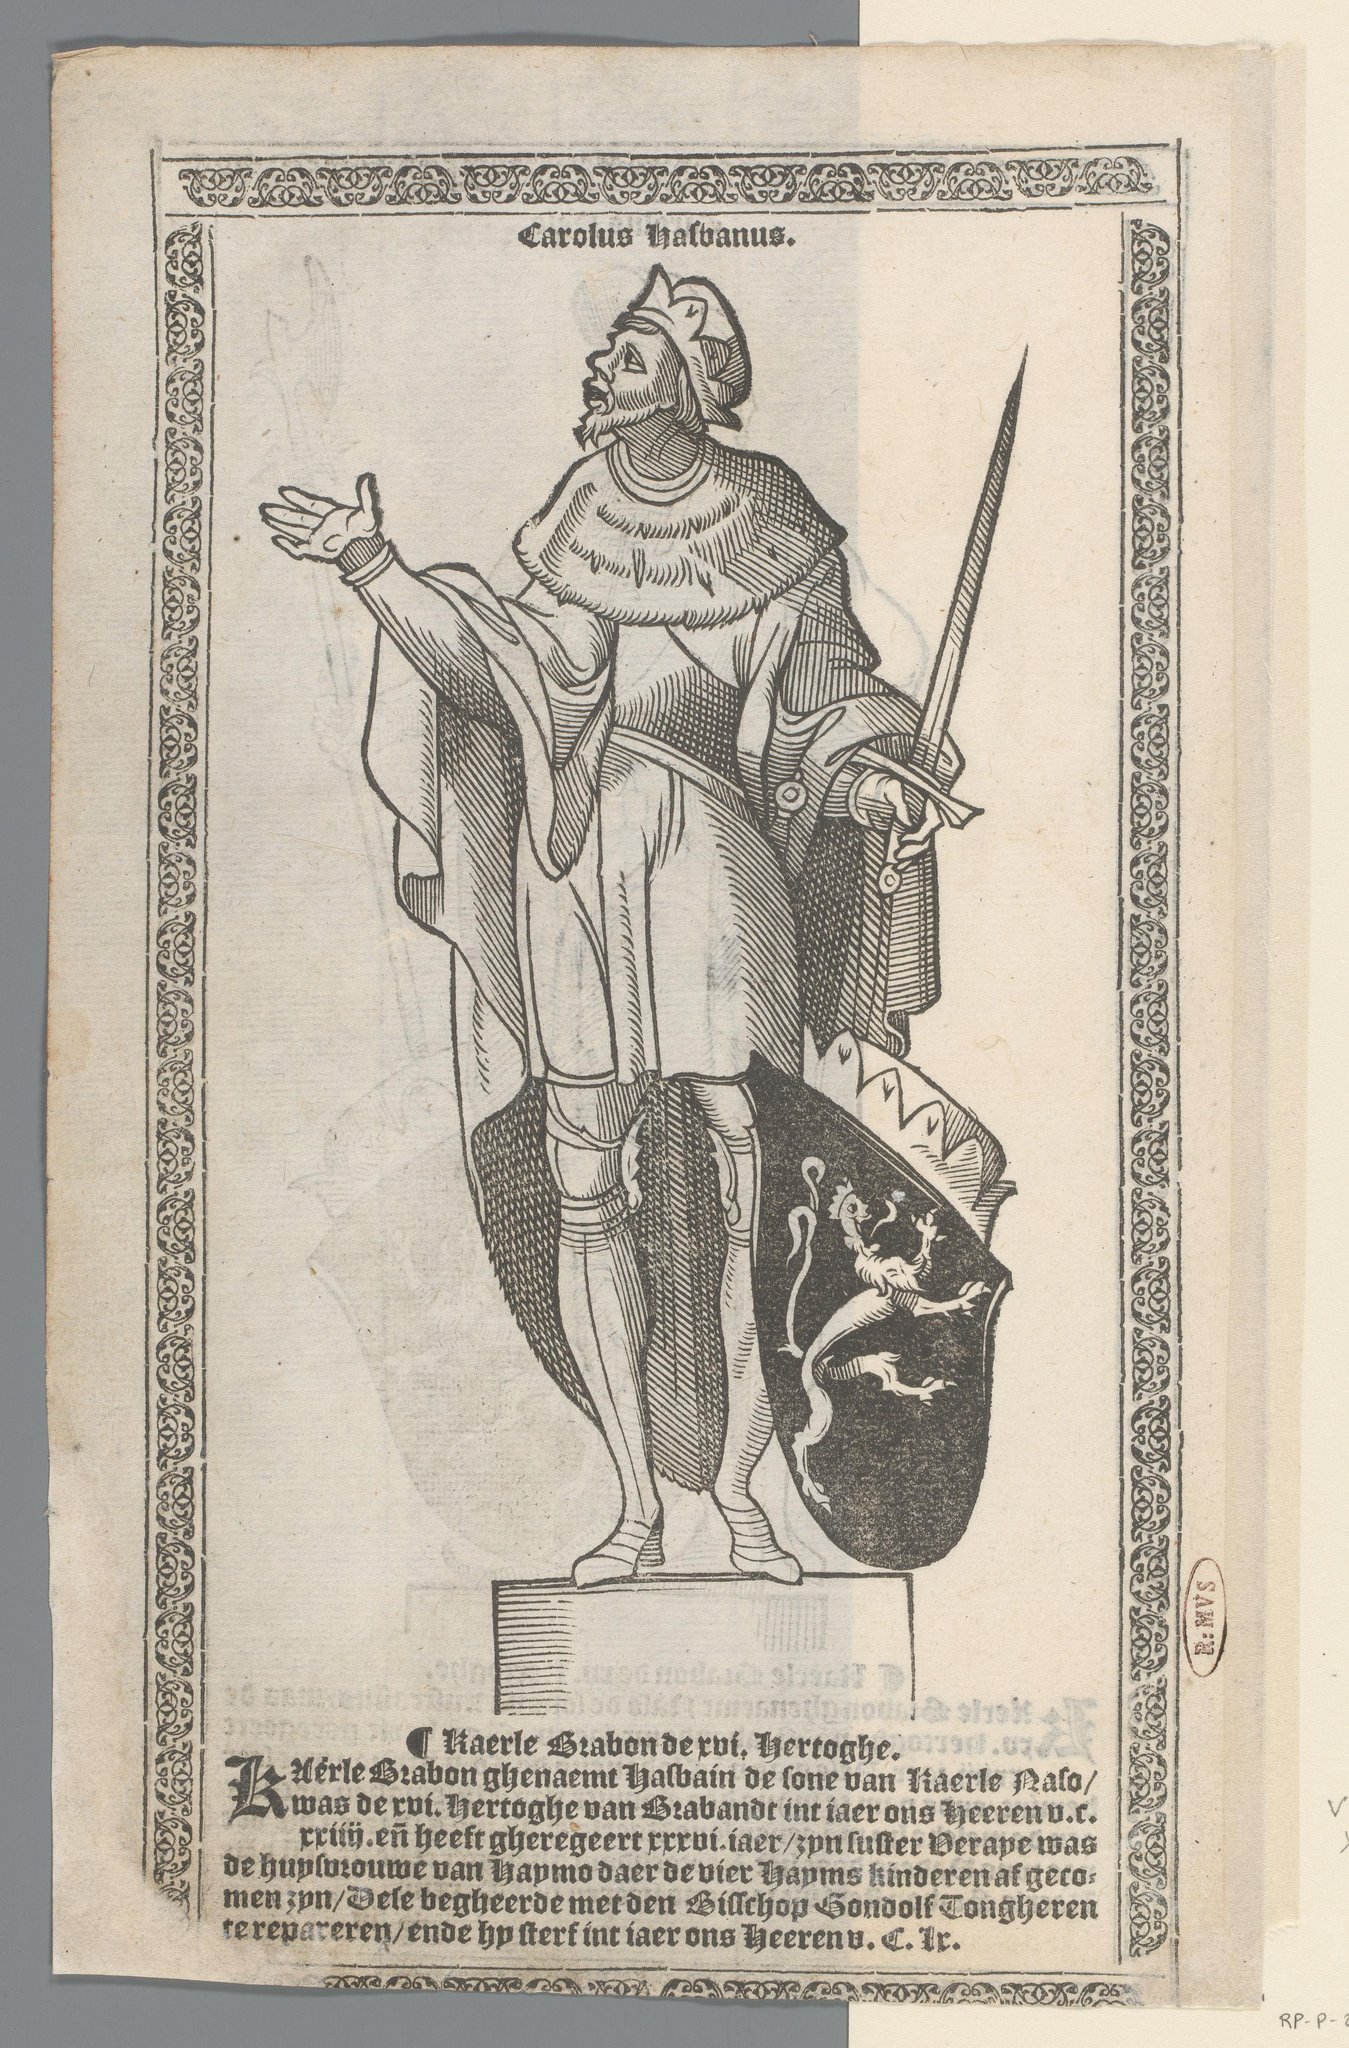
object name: print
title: Portret van Karel Hasban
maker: jan molijns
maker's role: print maker, publisher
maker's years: 1498-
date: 1565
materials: paper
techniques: letterpress printing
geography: antwerp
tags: hacking and thrusting weapons: sword, armorial bearing, heraldry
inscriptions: collector's mark: Lugt 2228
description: Prent uit: Dit is die afcoemste ende genalogie der hertoghen ende hertoginnen van Brabandt, (...). Antwerpen: Jan Molijns, 1565.